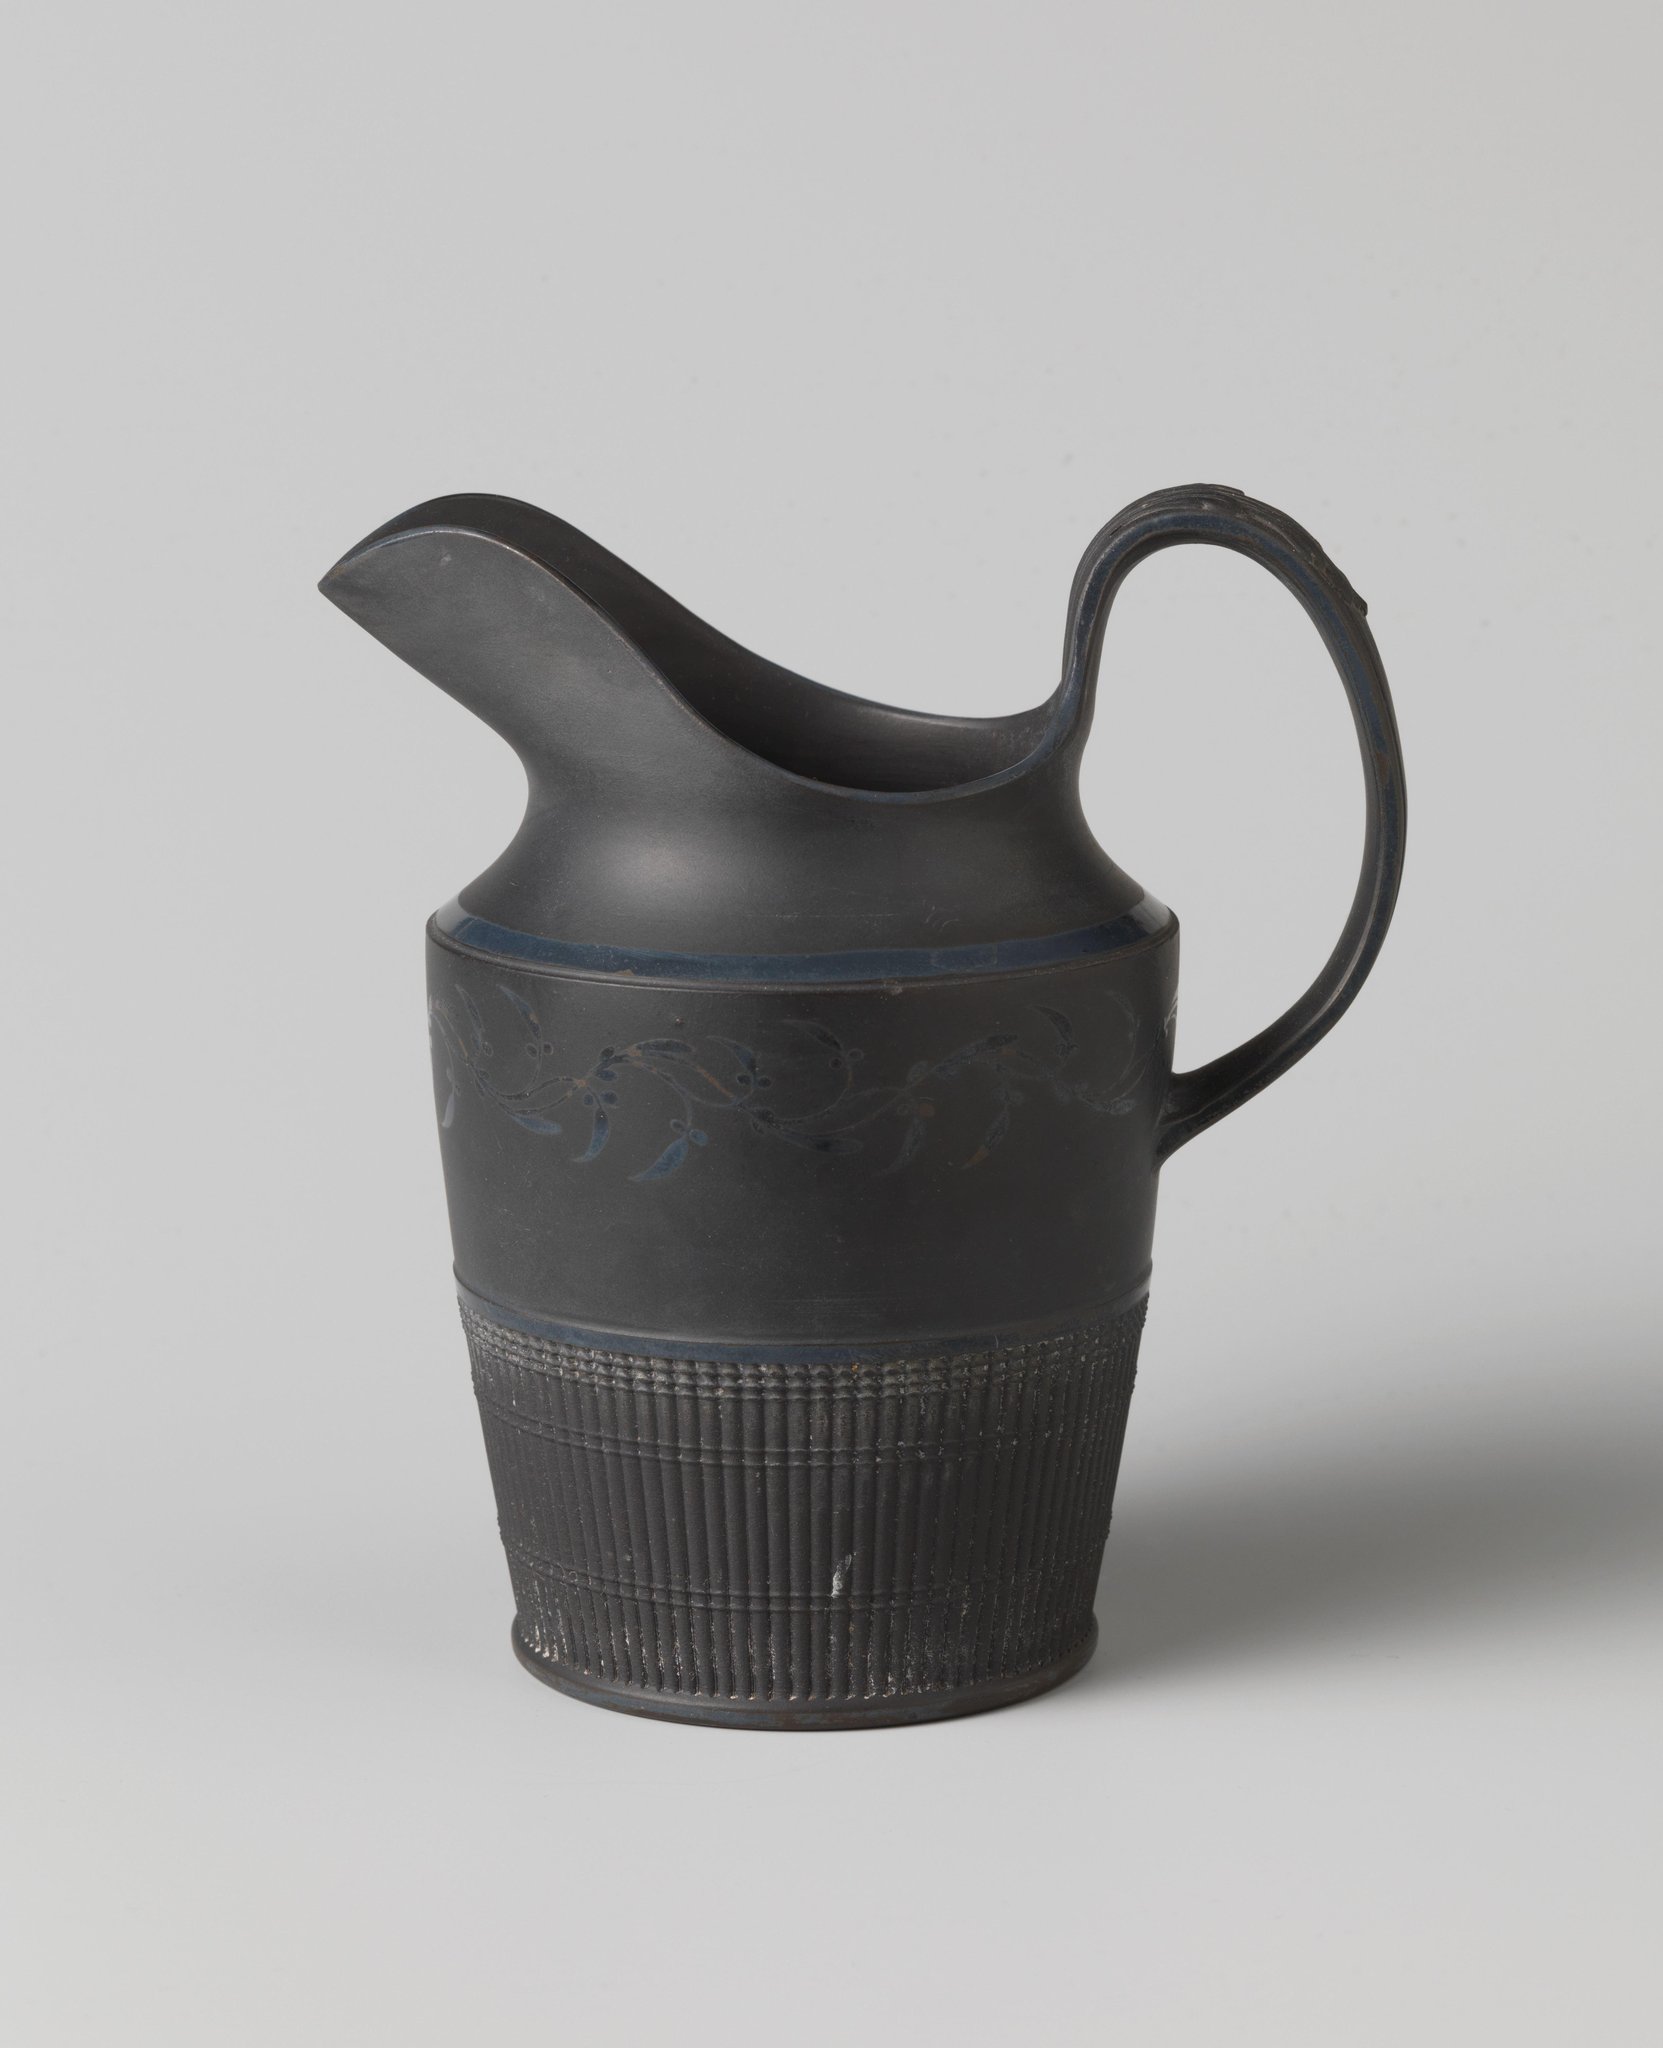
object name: ewer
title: Melkkan van aardewerk, Neale & Palmer Black Basalt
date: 1790-1825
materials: earthenware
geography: hanley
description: Bekervormige melkkan van aardewerk, Black Basalt. De kan heeft een brede lip en een C-vormig oor. De onderste helft van de kan is geribd. Langs de bovenrand loopt een zilverkleurige bladrank.